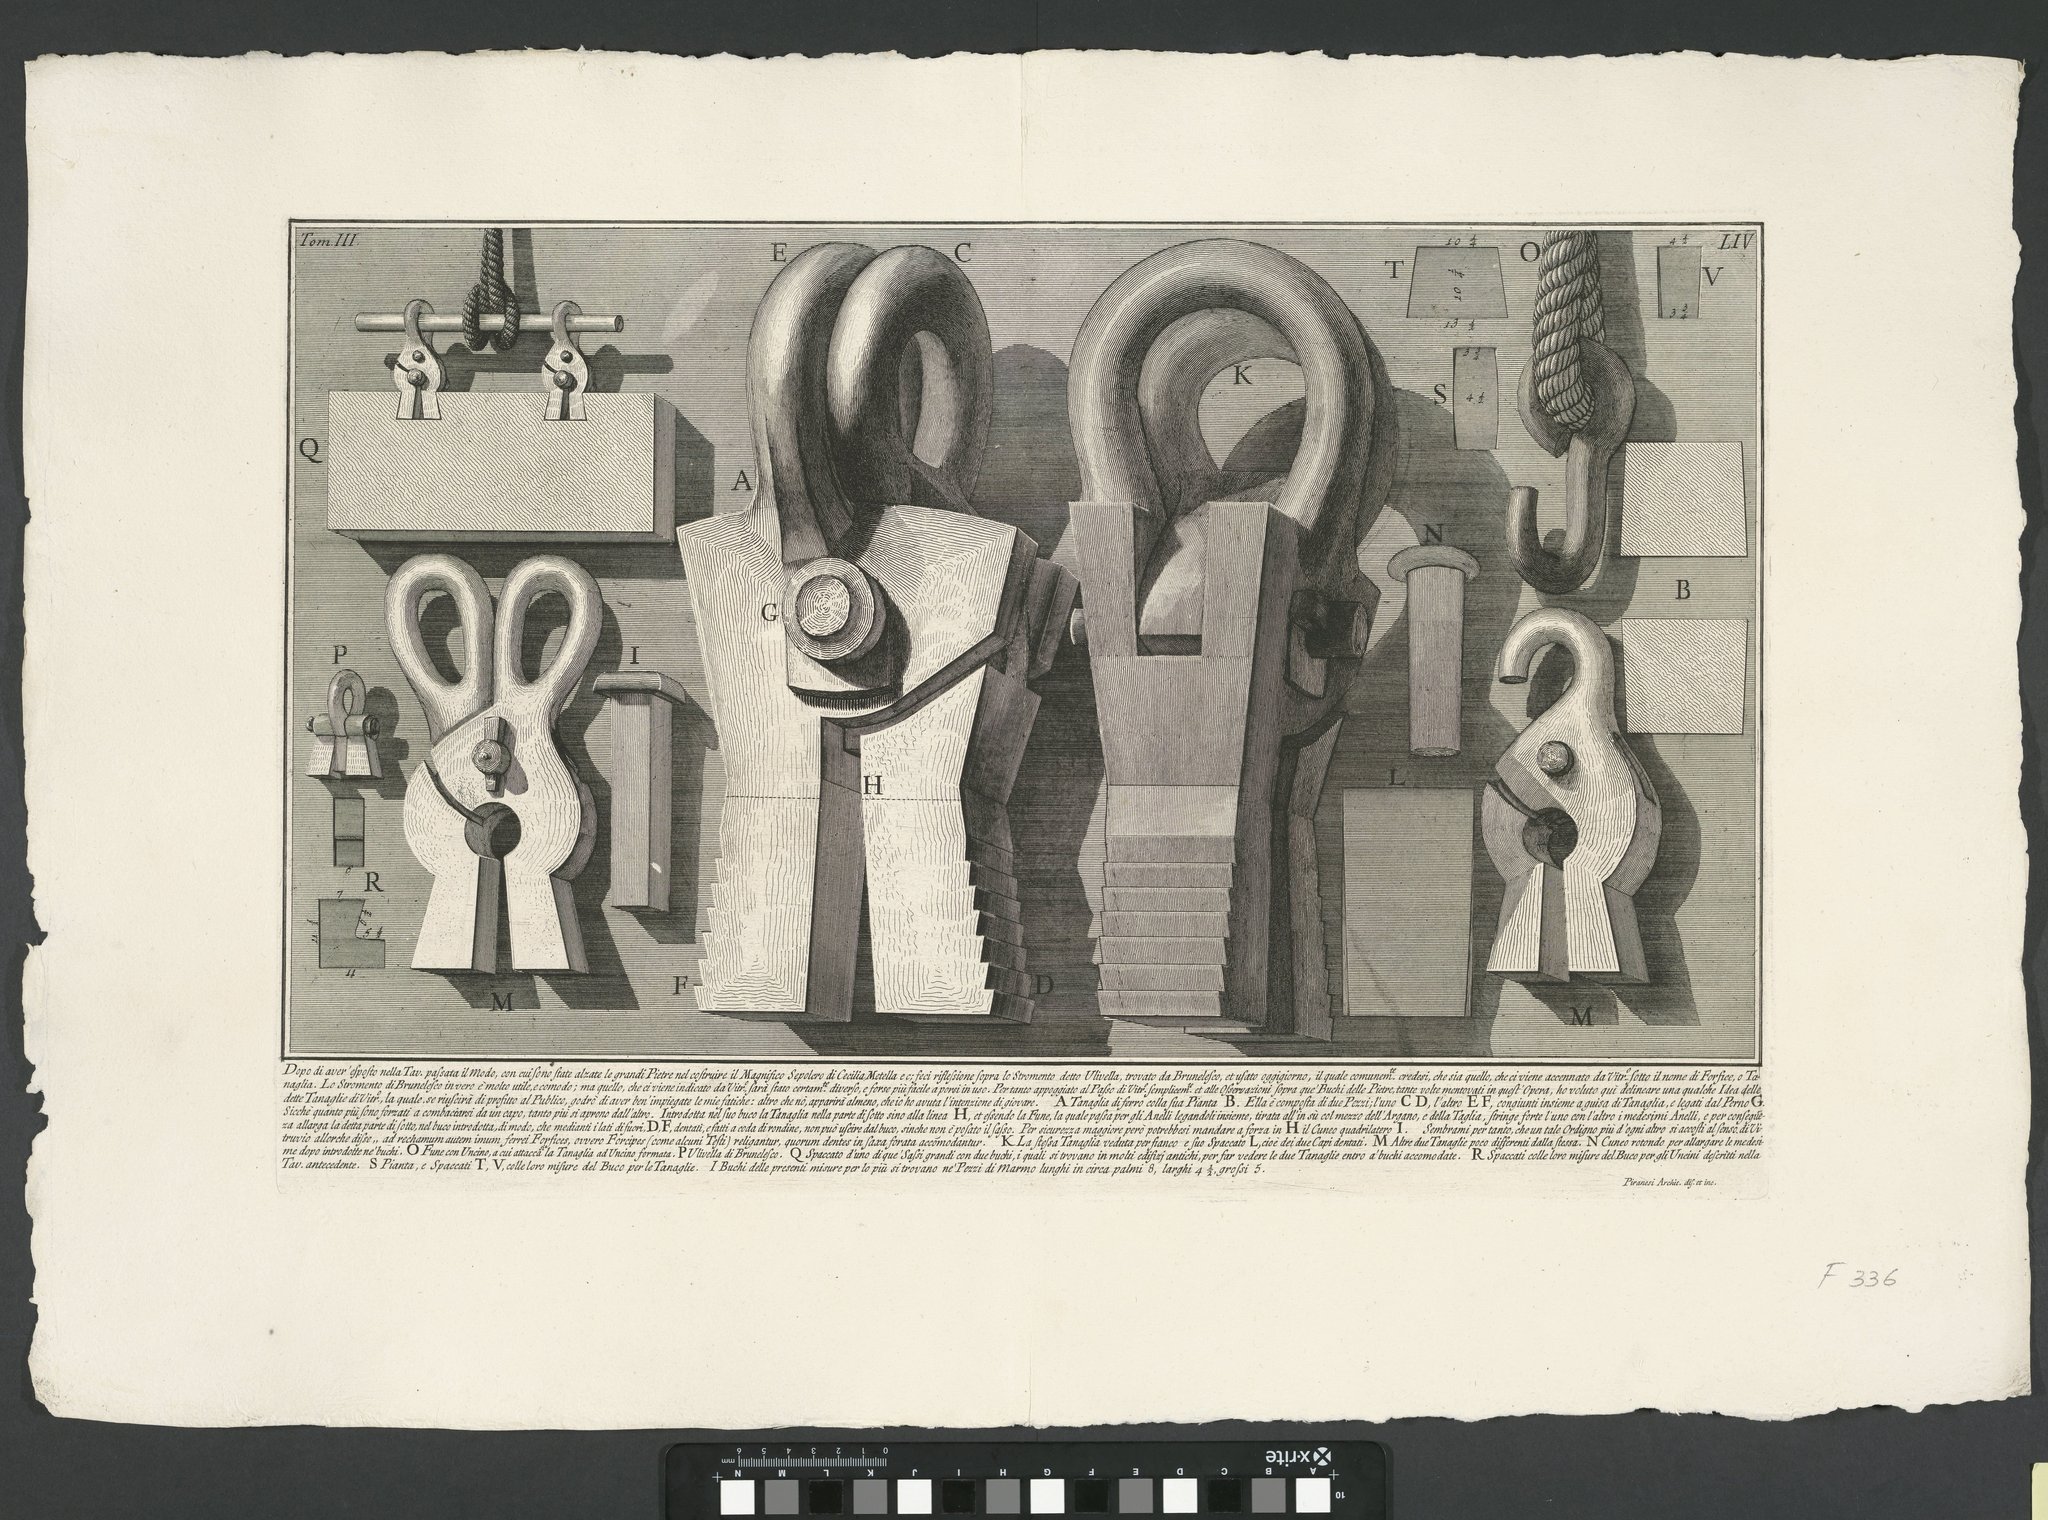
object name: print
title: Le Antichità Romane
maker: giovanni battista piranesi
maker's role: designer, draughtsman, print maker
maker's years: 1720-1778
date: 1756-1757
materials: paper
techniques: etching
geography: rome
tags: tools and machines ~ building, rome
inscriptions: collector's mark: Lugt 2228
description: Deze prent maakt deel uit van de serie 'Le Antichità Romane'. Piranesi deed meer dan acht jaar voorstudie voor deze 250 platen tellende serie die in vier volumes werd uitgegeven. Hij produceerde de prenten tussen ca. 1756 en 1757. De serie bevat ook prenten door of naar andere prentmakers, onder wie Francesco Bianchini en Girolamo Rossi.